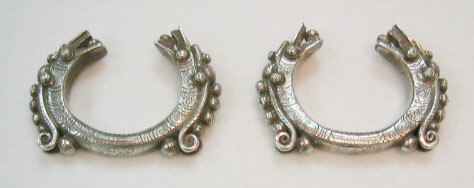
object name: bracelet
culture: thai, lu mien yao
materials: silver